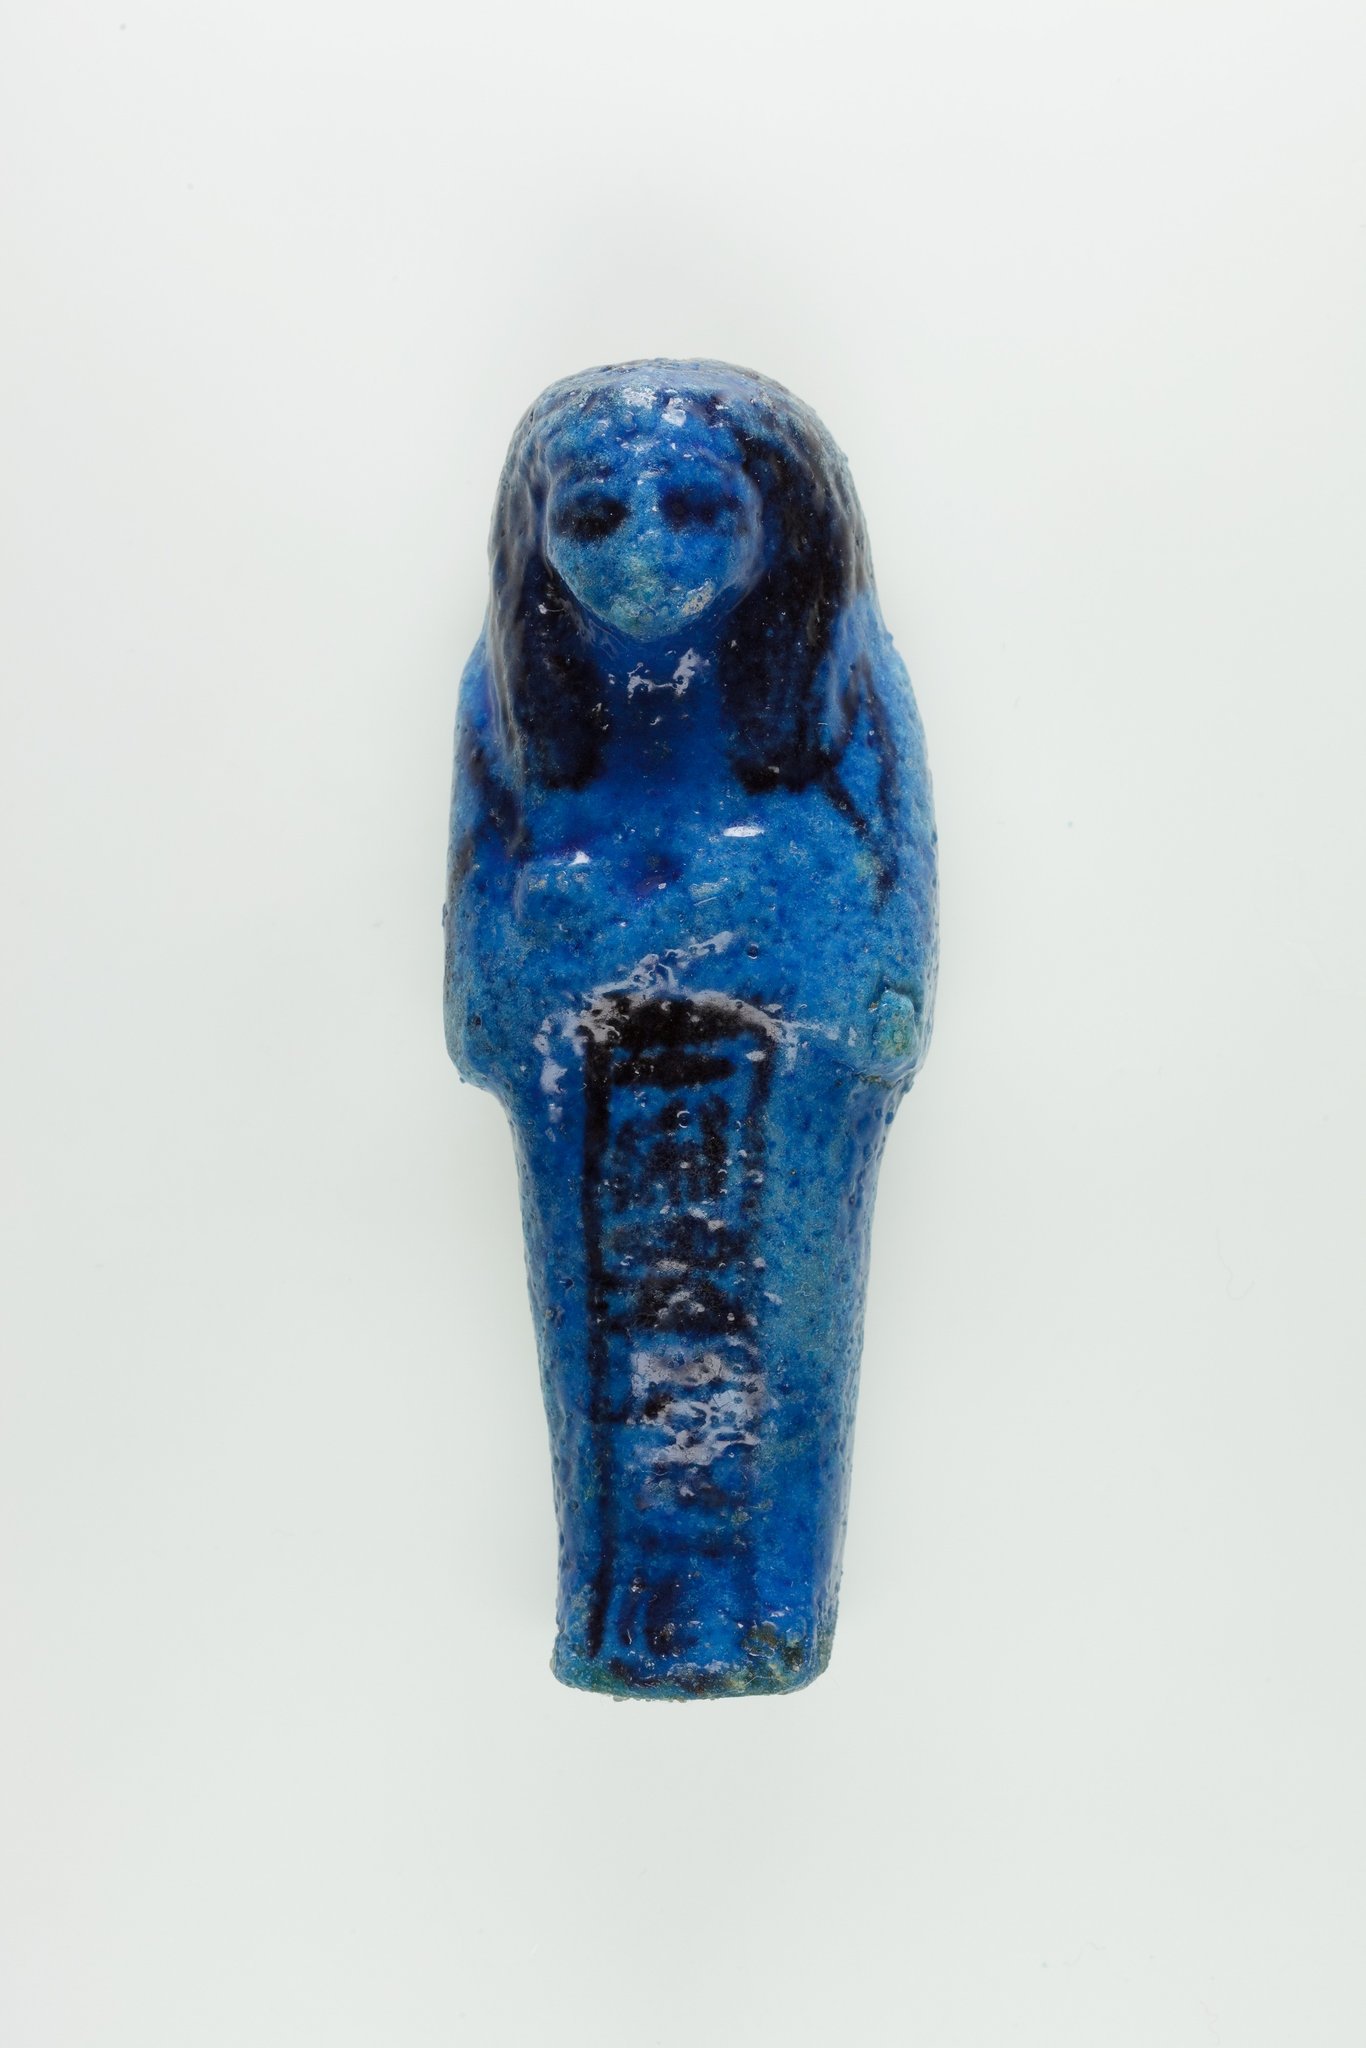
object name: shabti, worker, nauny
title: Worker Shabti of Nauny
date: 1050 BCE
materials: faience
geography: egypt